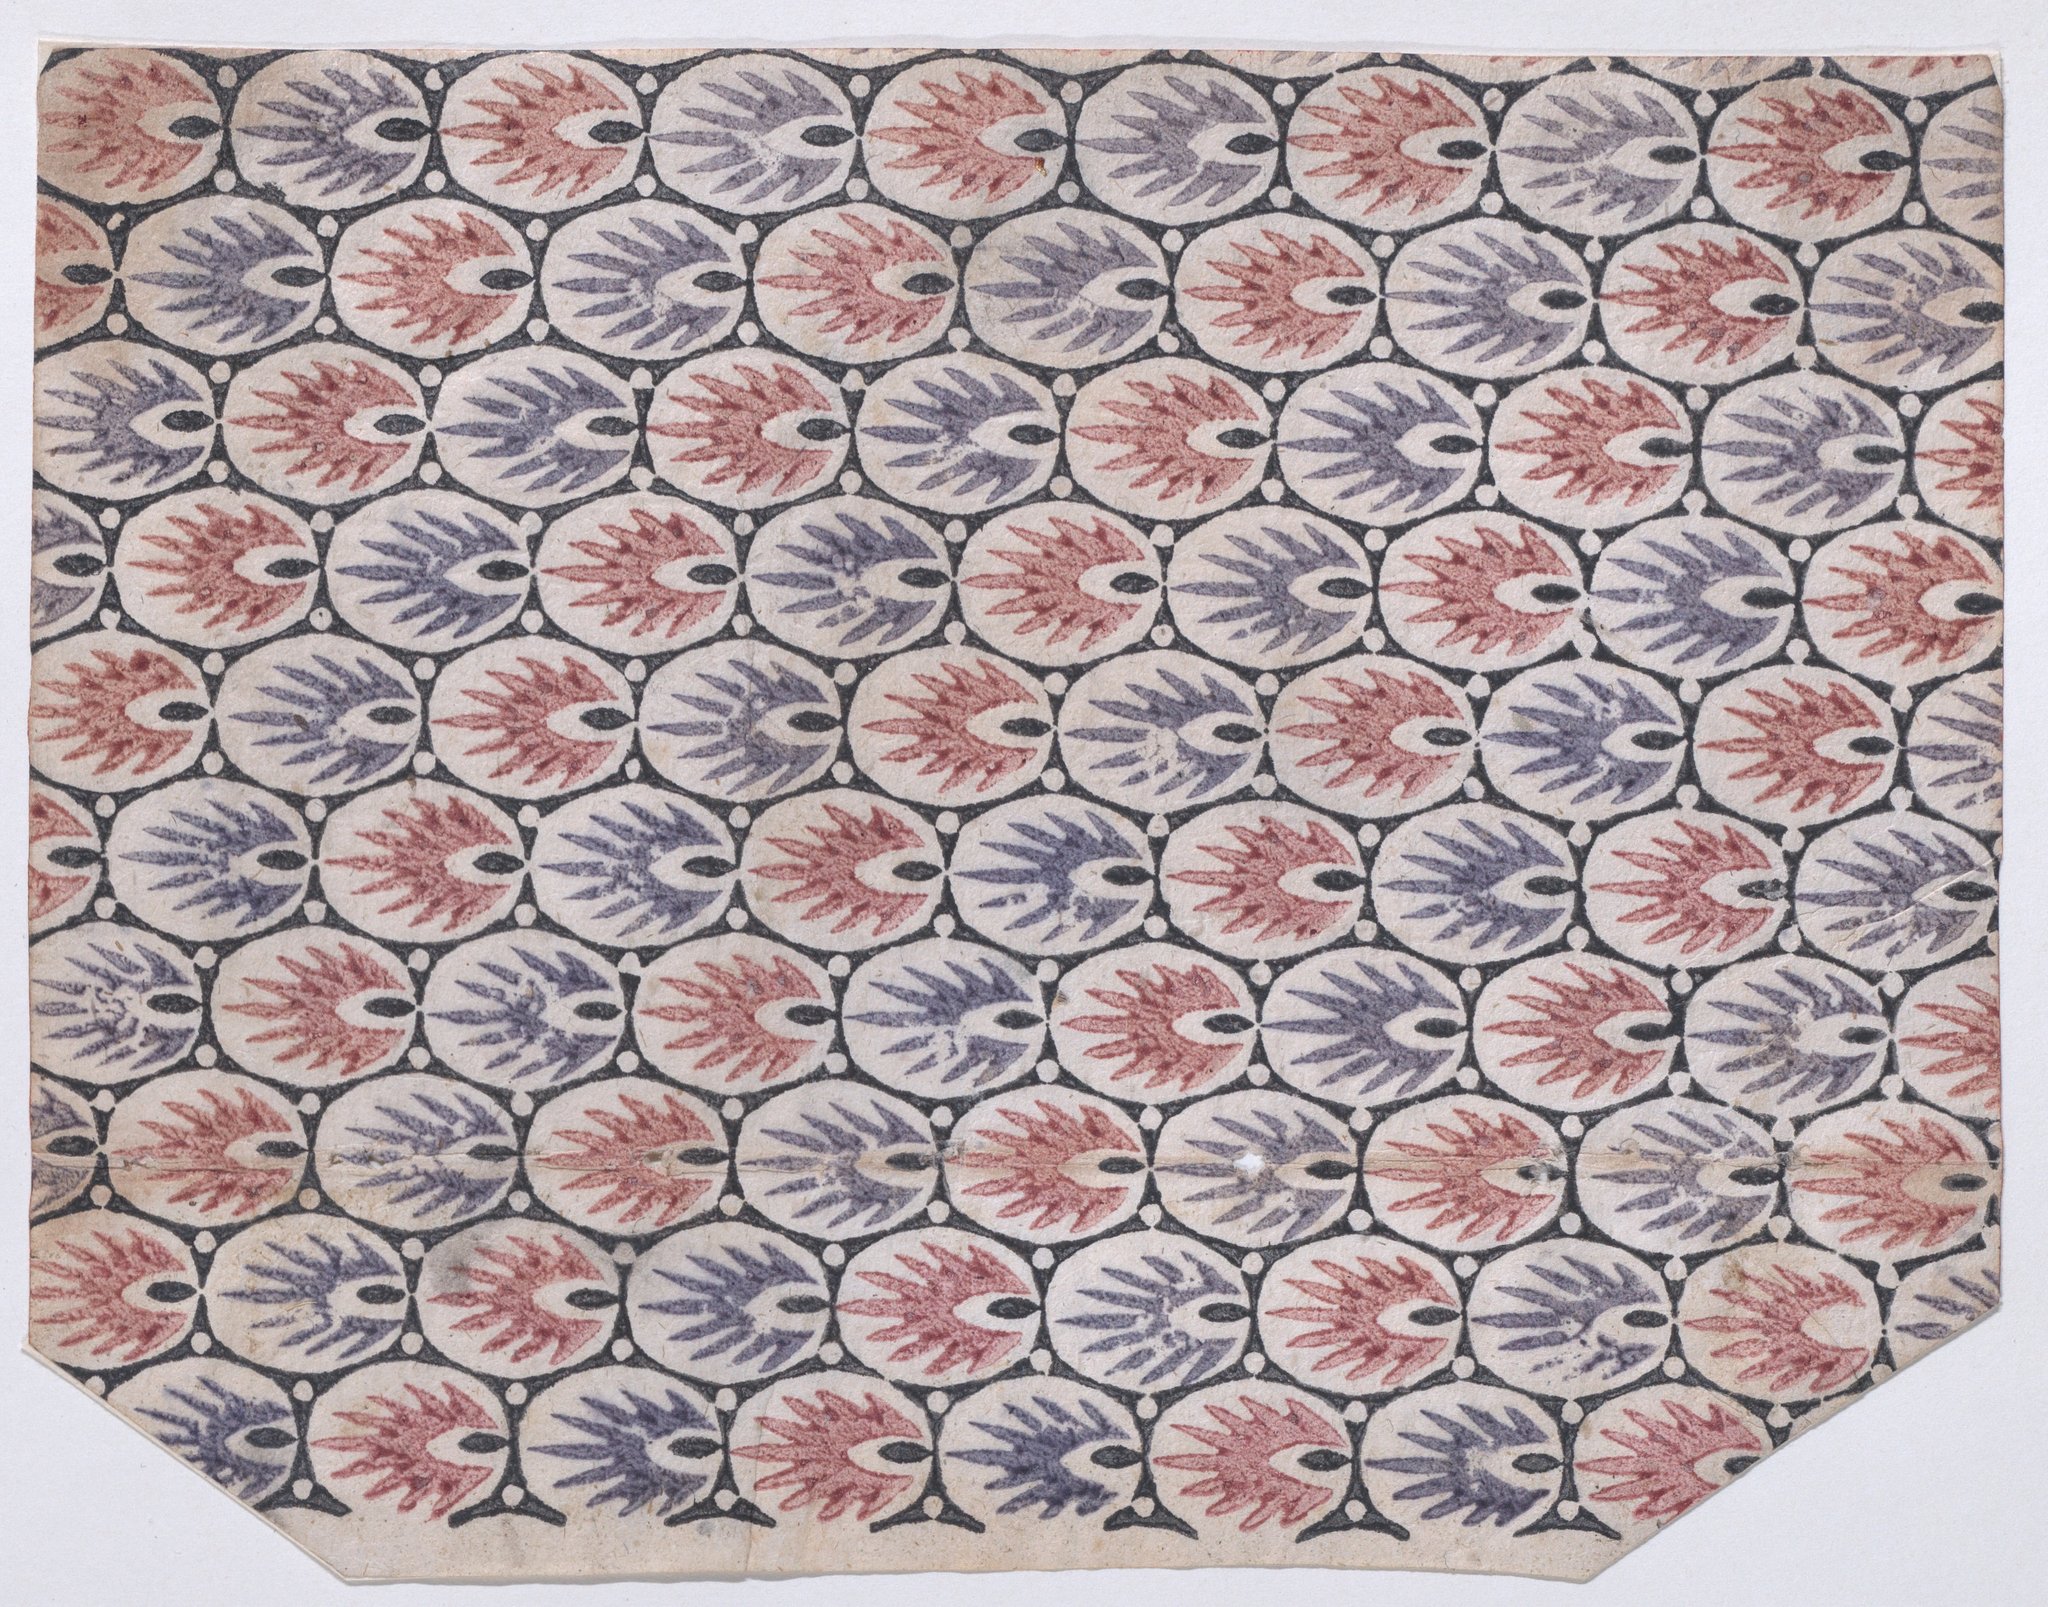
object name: print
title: Sheet with overall pattern of pointed shapes within ovals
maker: Anonymous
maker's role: artist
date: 1801-1900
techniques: relief print